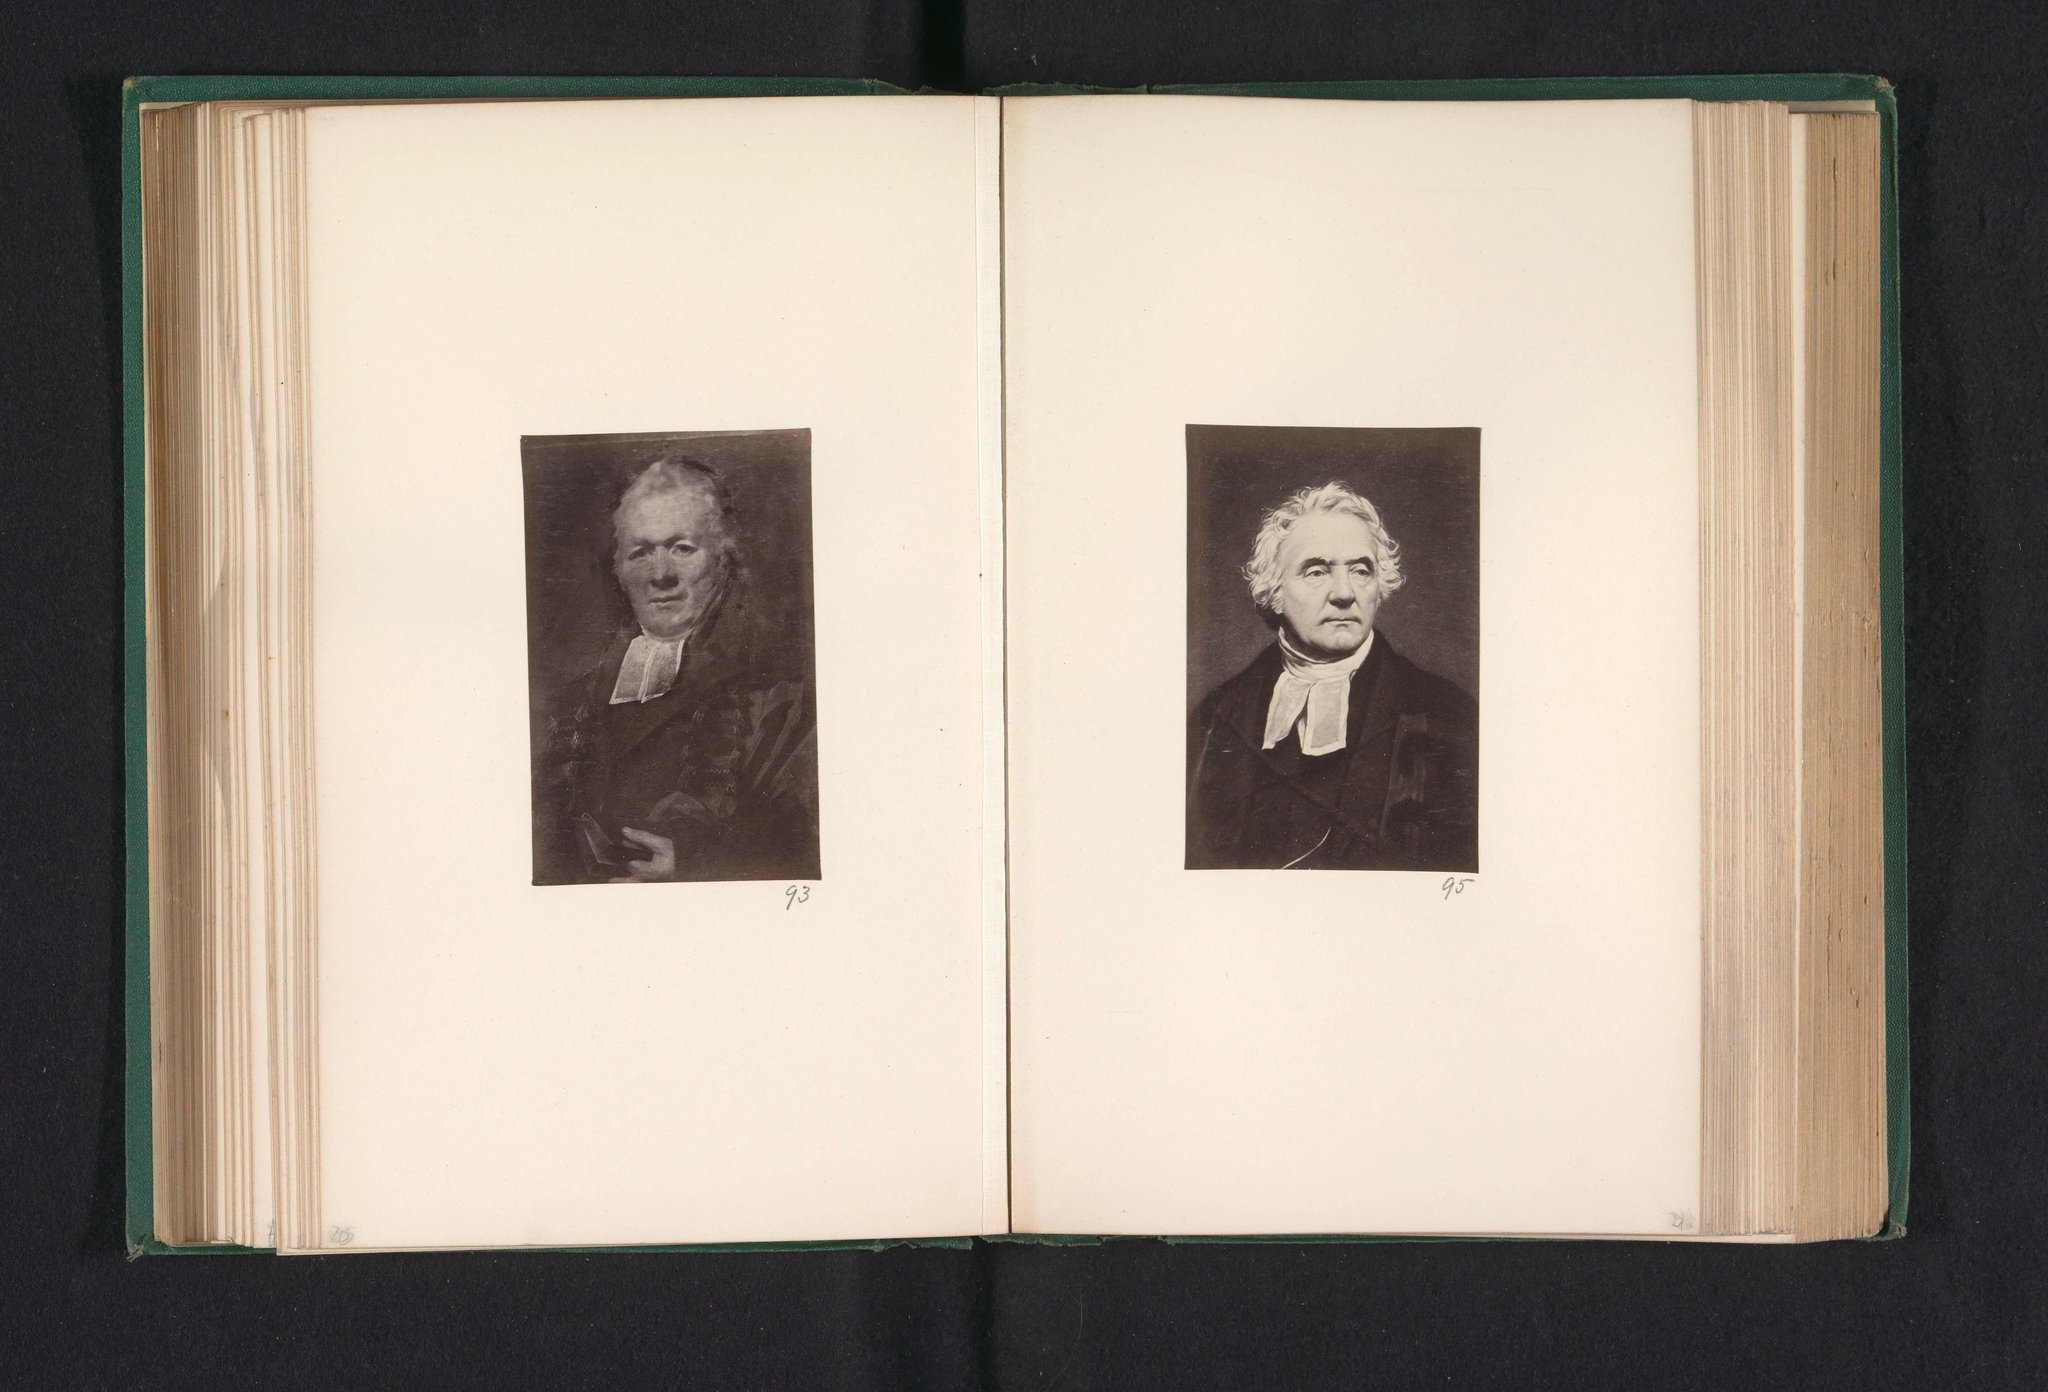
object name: page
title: Fotoreproductie van een schilderij, voorstellende een portret van Thomas Chalmers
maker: thomas annan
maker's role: fotograaf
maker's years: 1829-1887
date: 1863-1868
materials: photographic support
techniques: albumen print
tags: historical persons (portraits and scenes from the life) (+ (full) bust portrait)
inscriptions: number: ‘95’